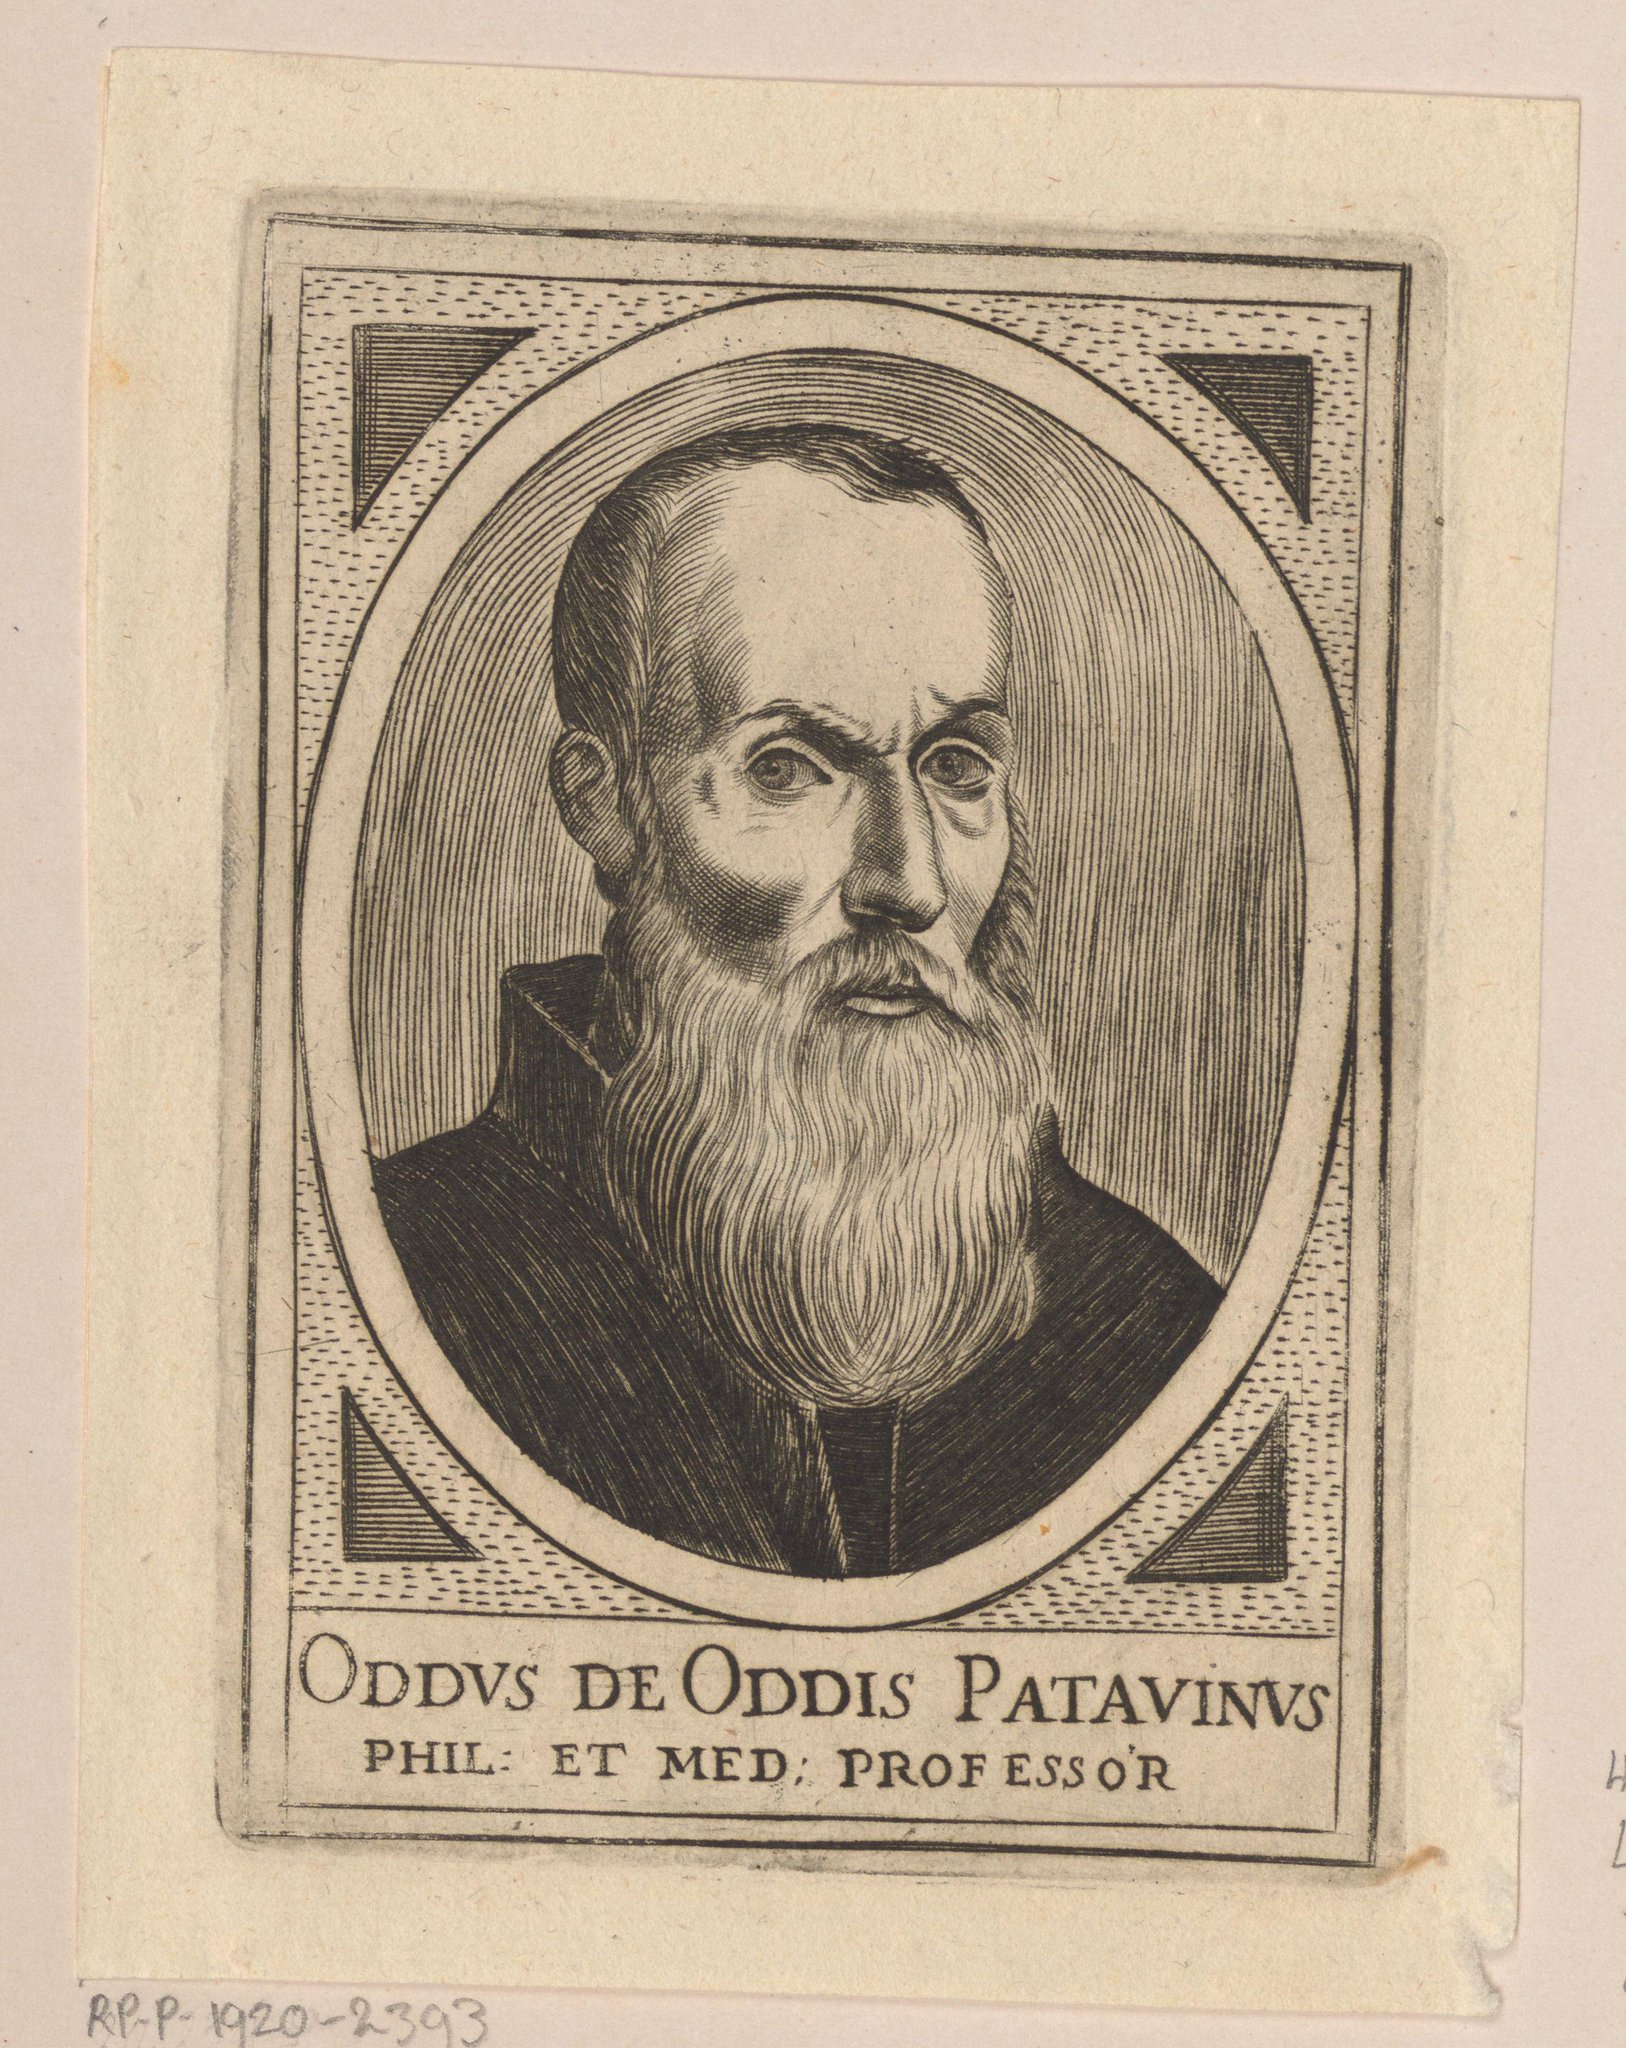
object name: print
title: Portret van Oddo degli Oddi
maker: Anonymous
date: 1630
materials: paper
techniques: engraving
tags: historical persons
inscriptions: collector's mark: Lugt 2228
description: Prent mogelijk uit: Tomasini, Giacomo Filippo. Illustrium virorum elogia iconibus exornata (...). Padua: Donatum Pasquardum, 1630.